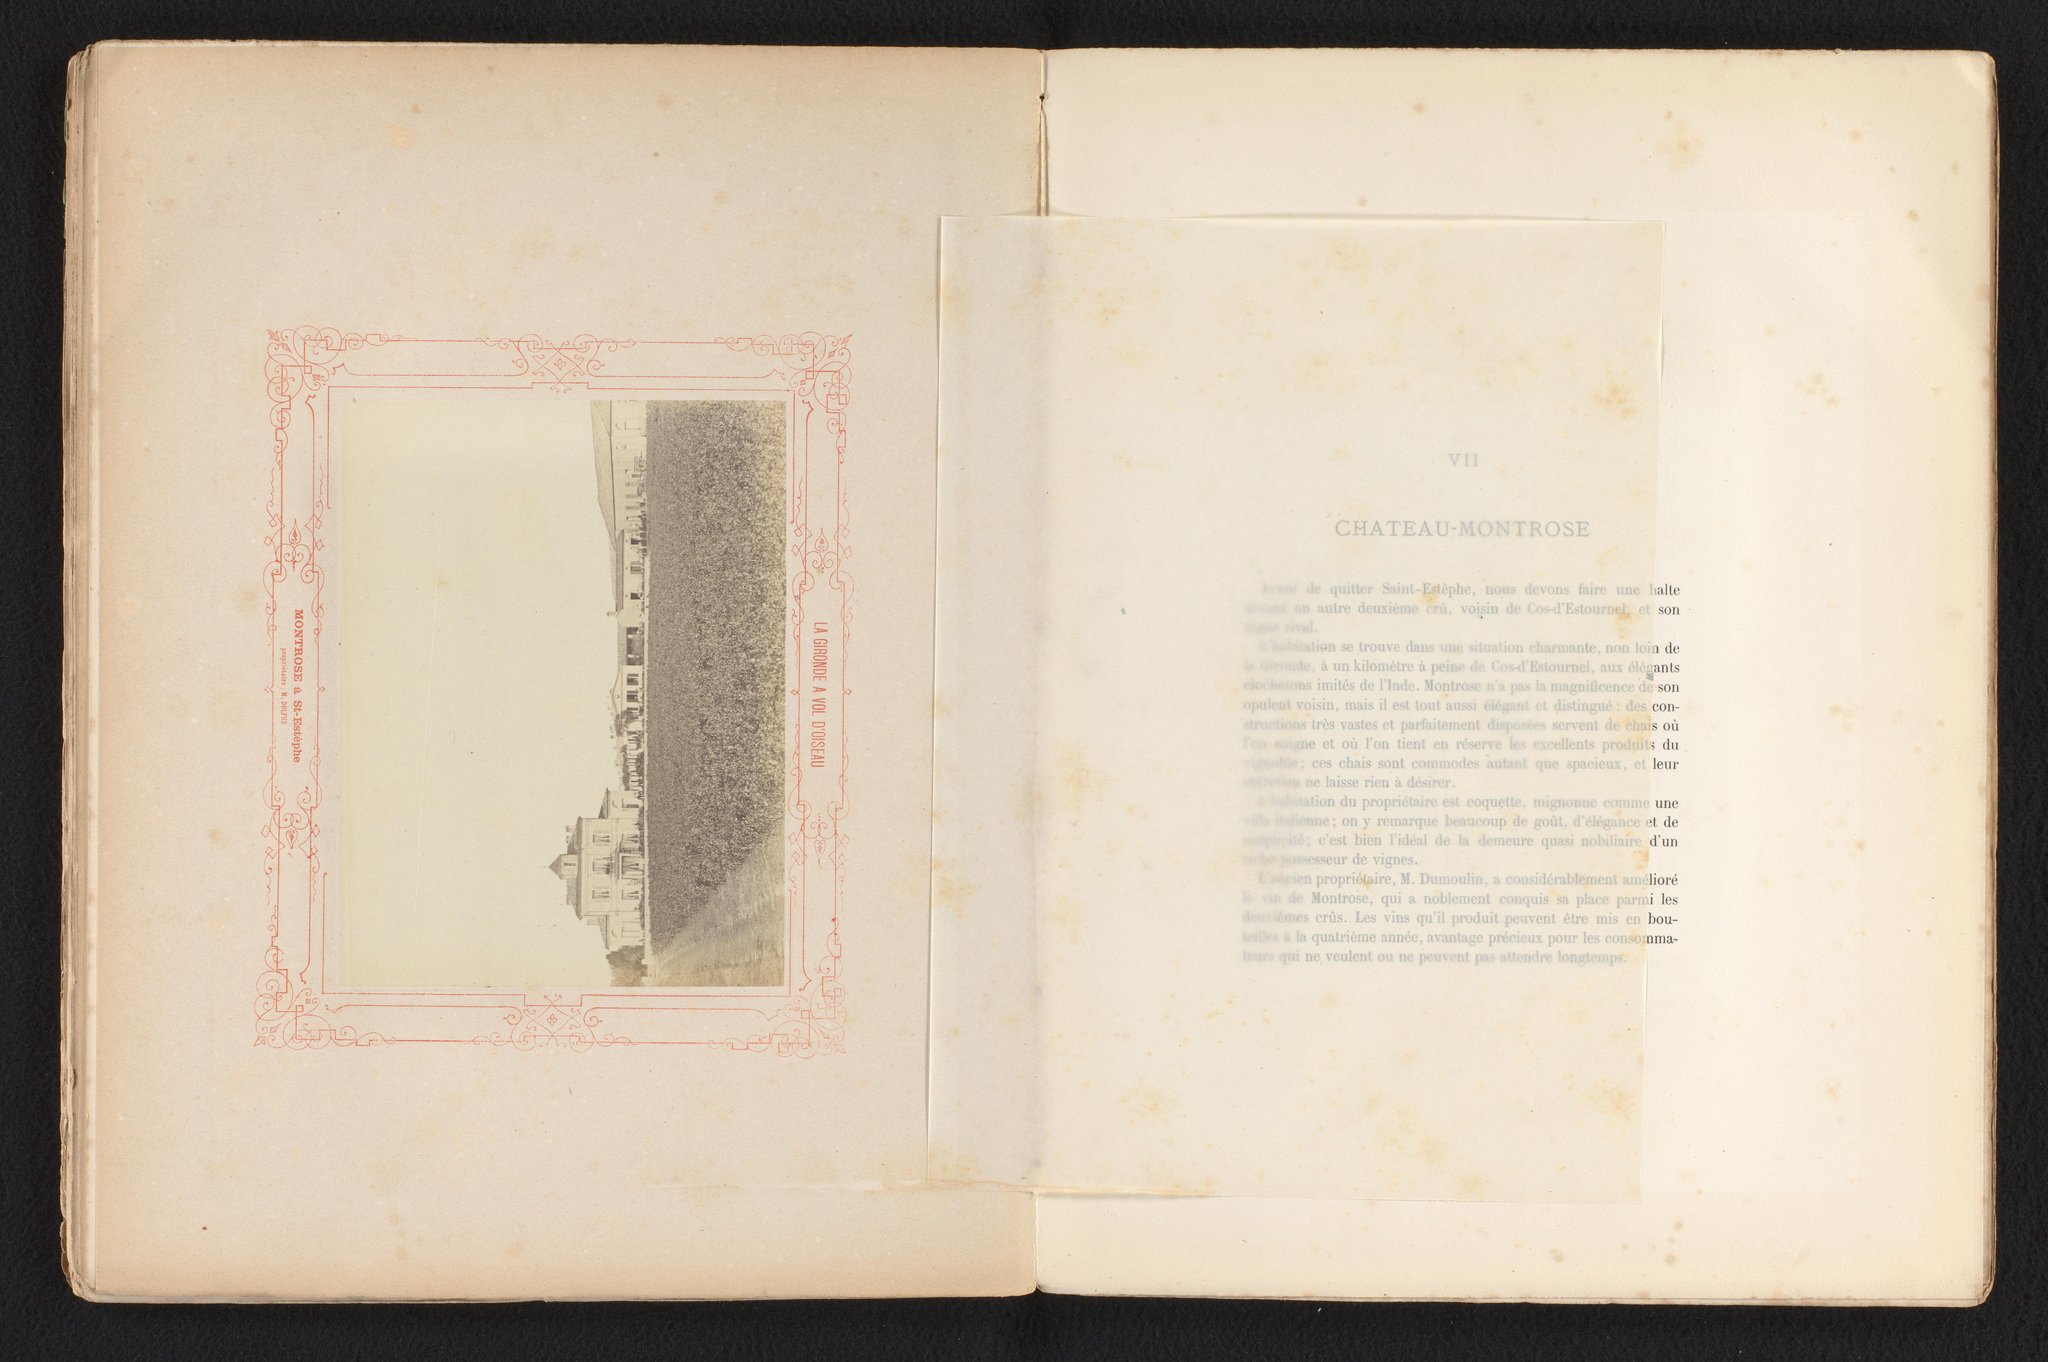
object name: photograph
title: La Gironde à Vol d'Oiseau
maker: alfred danflou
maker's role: fotograaf, schrijver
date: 1862-1867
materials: paper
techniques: albumen print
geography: saint-estèphe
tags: castle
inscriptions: inscription: ‘propriétaire: M. DOLFUS’